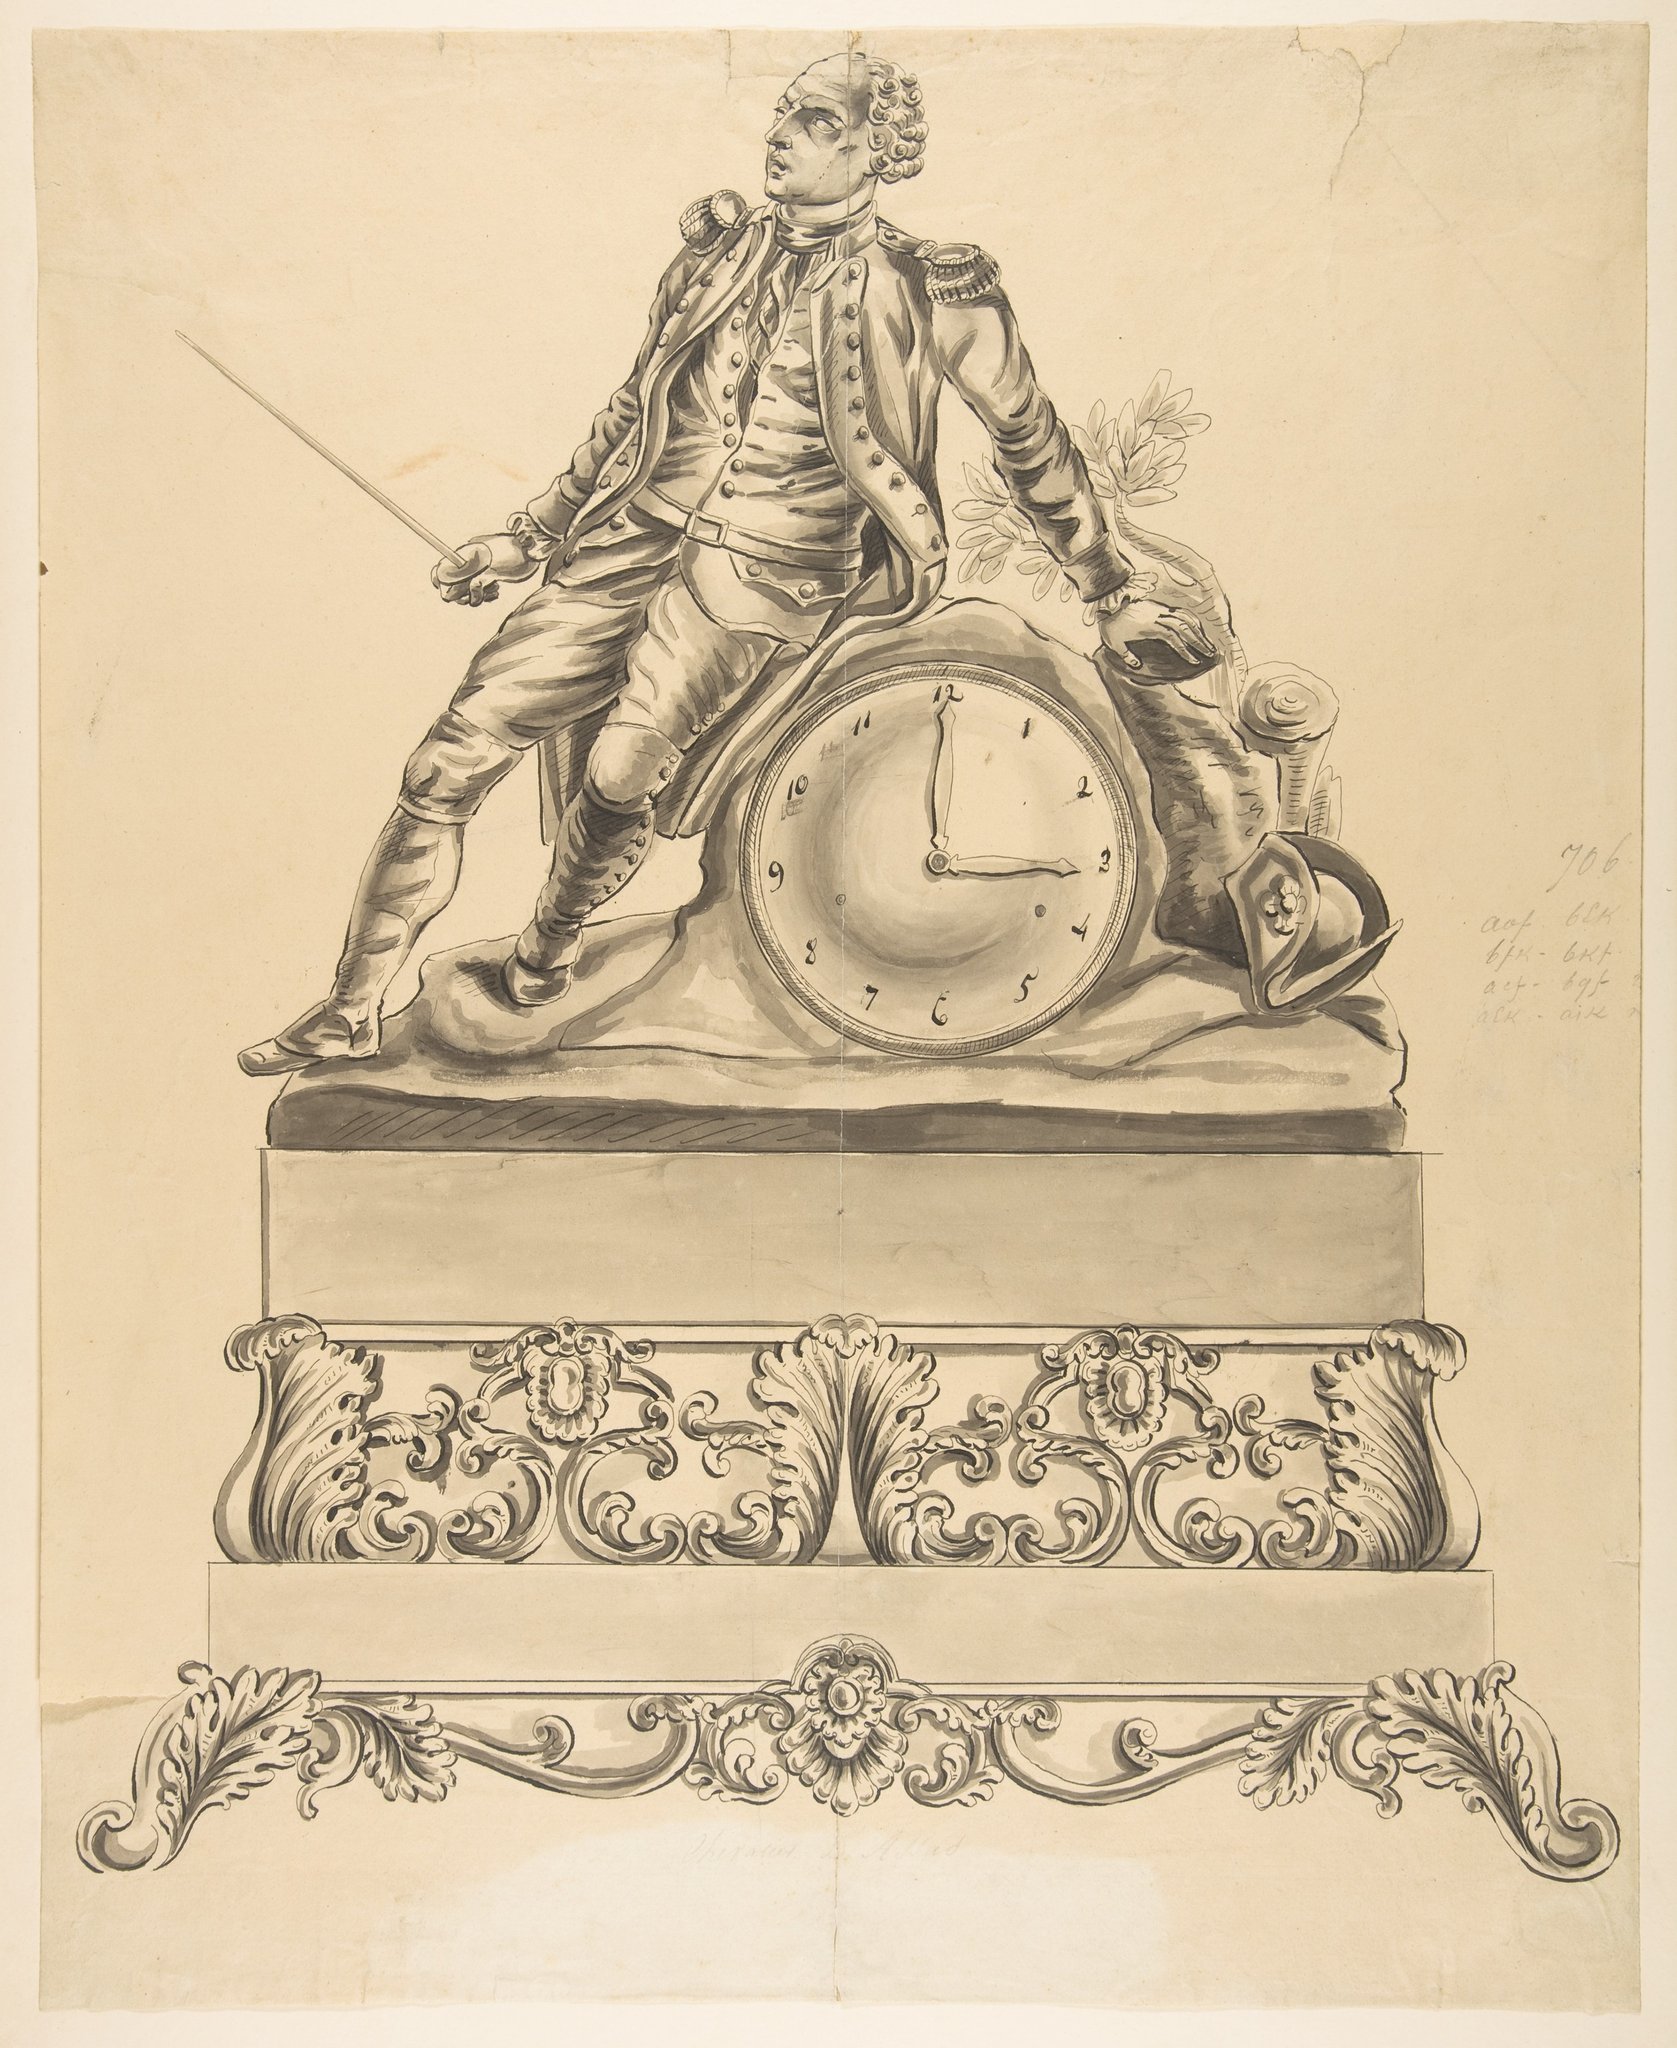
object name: drawing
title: Design for a Clock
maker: anonymous, french, 18th century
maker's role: artist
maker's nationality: french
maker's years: 1700-1800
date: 1701-1800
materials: ink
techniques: brush, pen, wash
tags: swords,palmettes,men,leaves,clocks